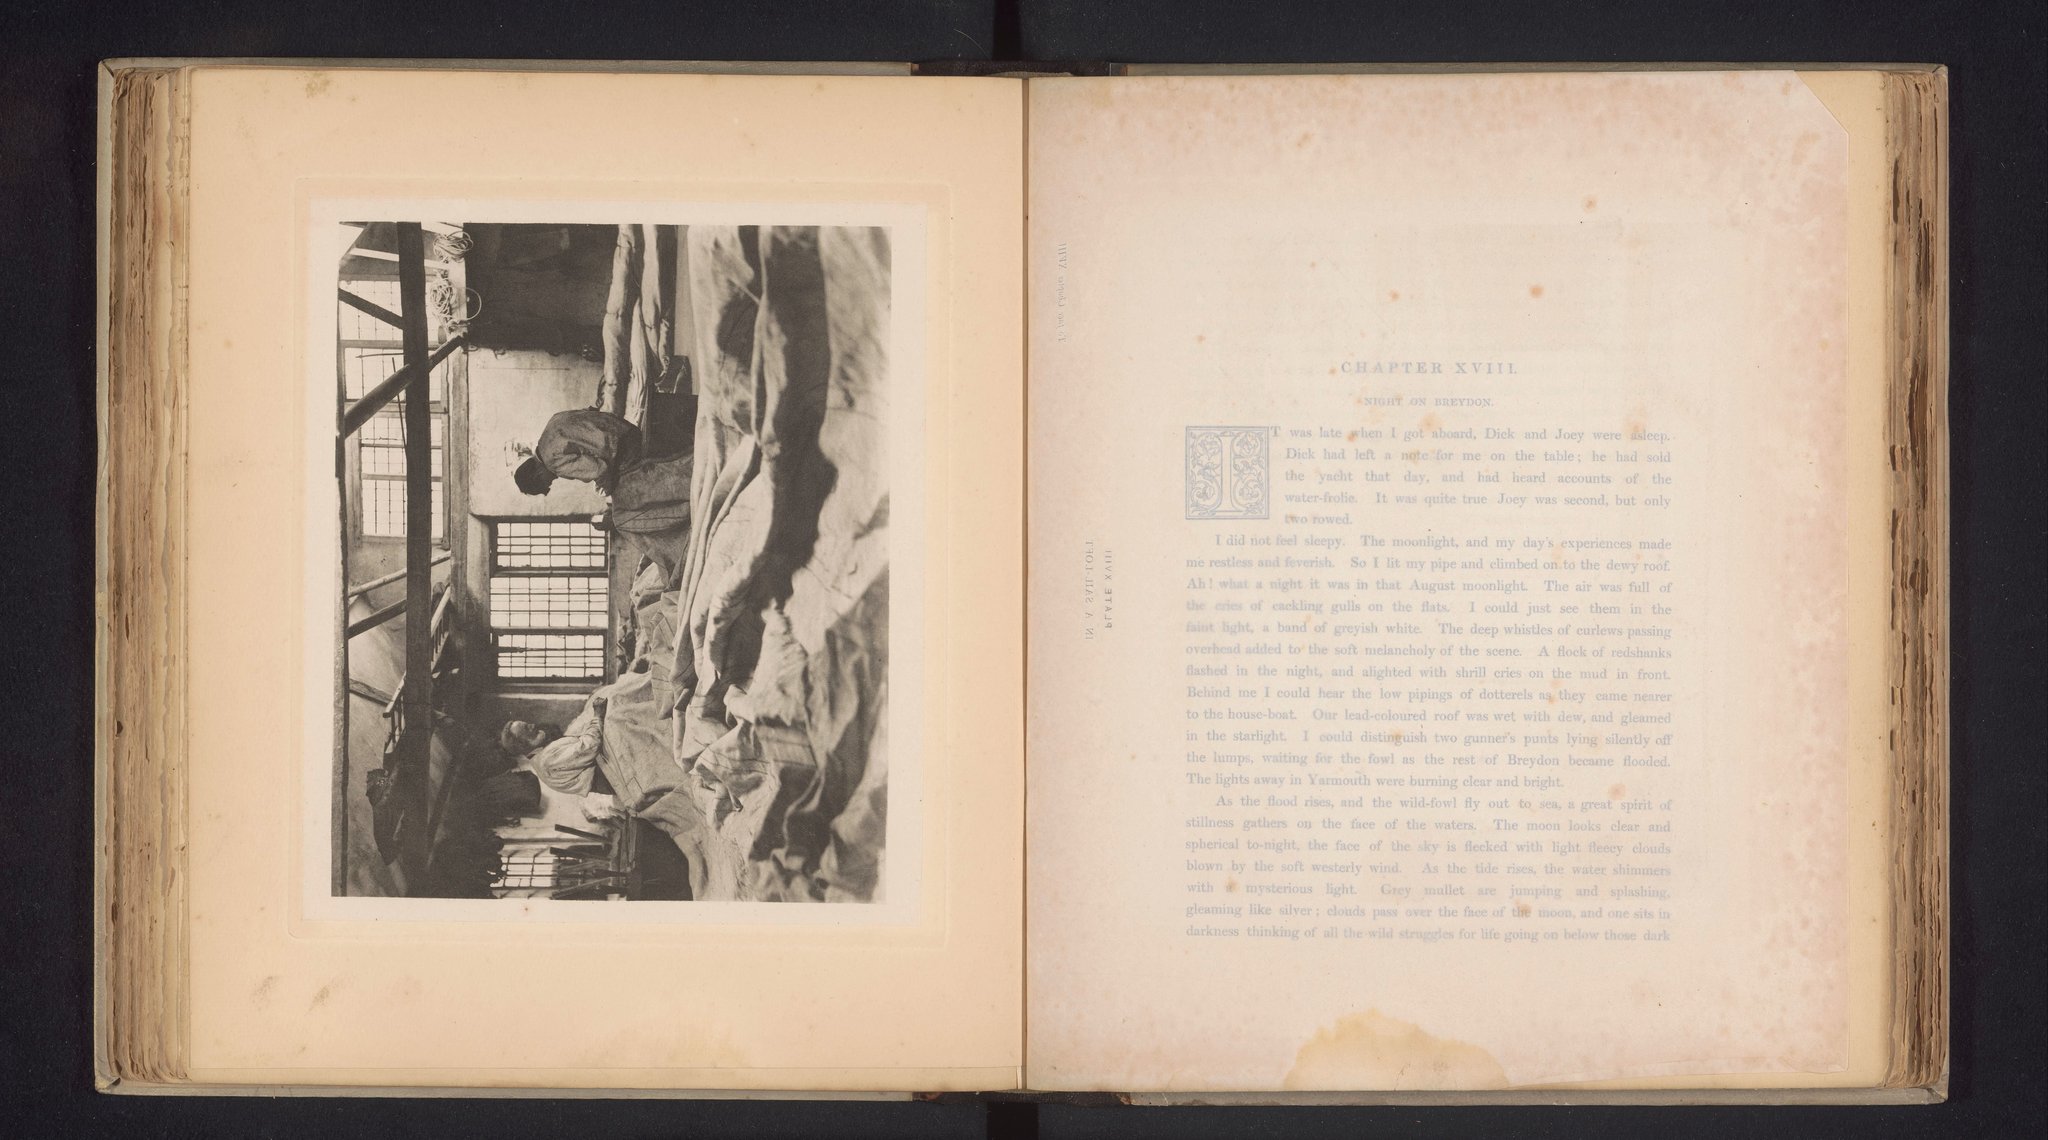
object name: photomechanical print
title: Interieur van een zeilmakerij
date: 1880-1890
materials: paper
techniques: photoaquatint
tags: sail, interior ~ representation of a building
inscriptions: inscription: ‘In a sail-loft’, number: ‘Plate XVIII’